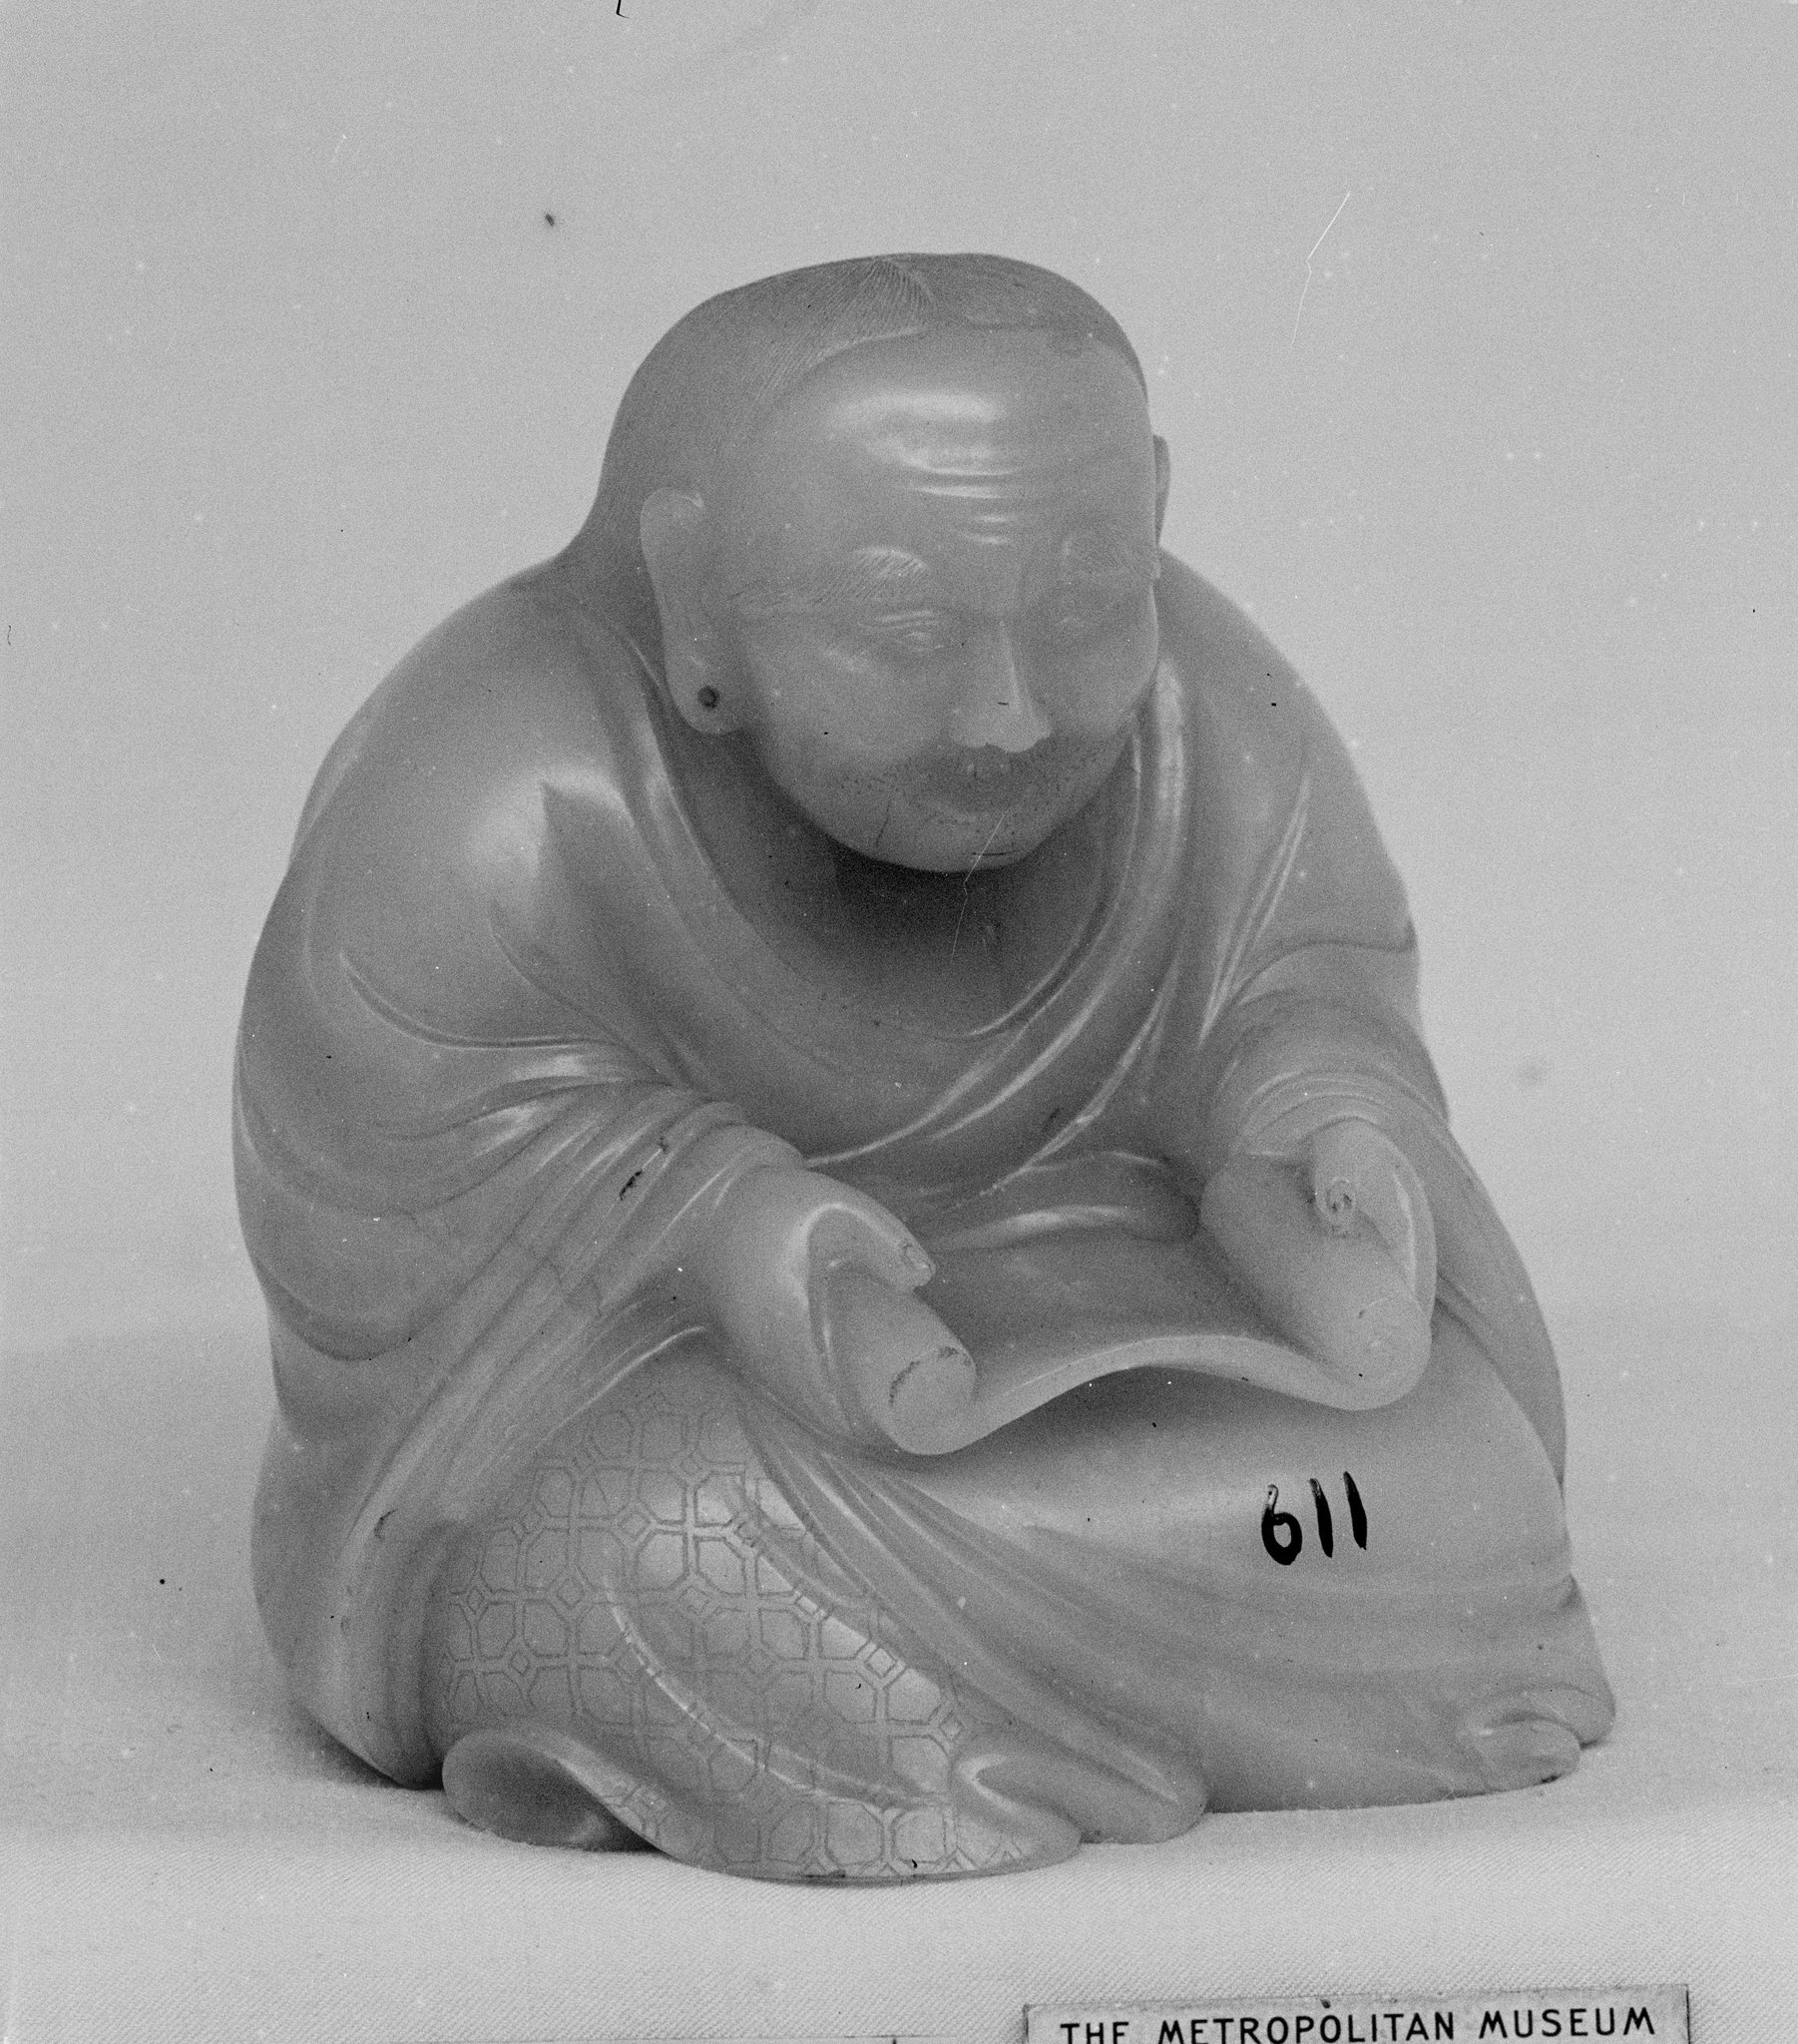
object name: figure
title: Luohan (Arhat)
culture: chinese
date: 1701-1800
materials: jade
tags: men,buddhism